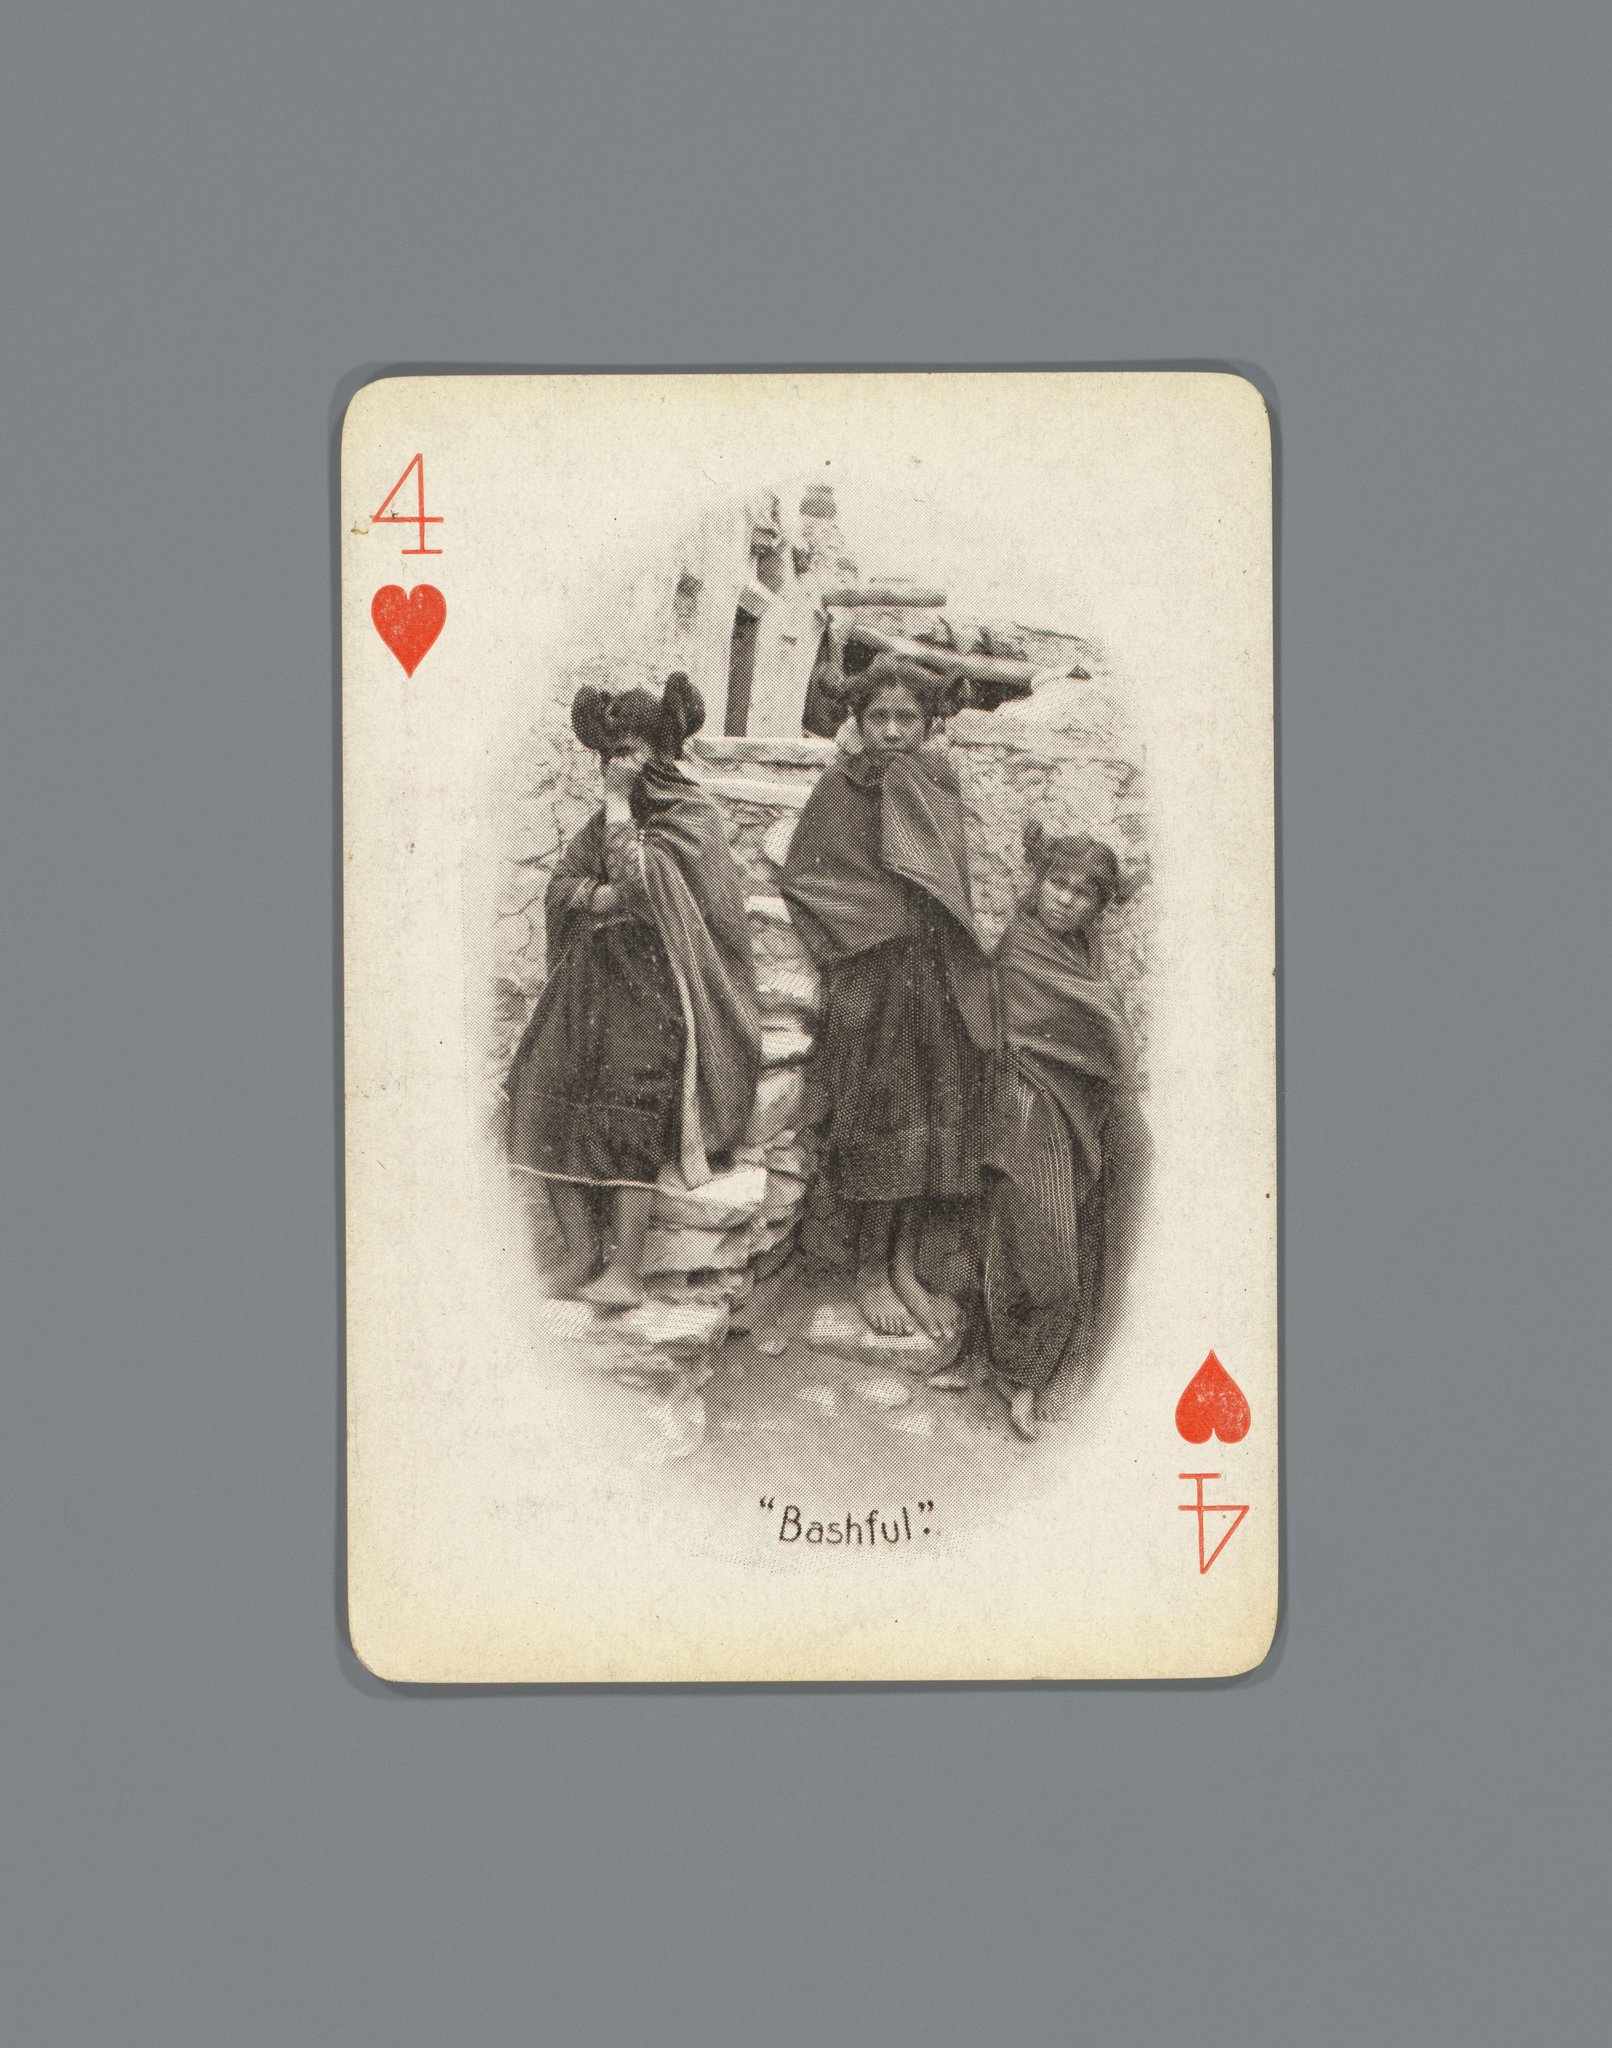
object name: photograph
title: Harten vier met drie jonge vrouwen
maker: adam clark vroman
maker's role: fotograaf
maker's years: 1856-1916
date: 1900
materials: paper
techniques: autotype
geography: united states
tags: united states of america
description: Speelkaart uit doosje met 53 speelkaarten met afbeeldingen in autotypie van Native Americans. De inhoud bevat een complete set speelkaarten inclusief joker.